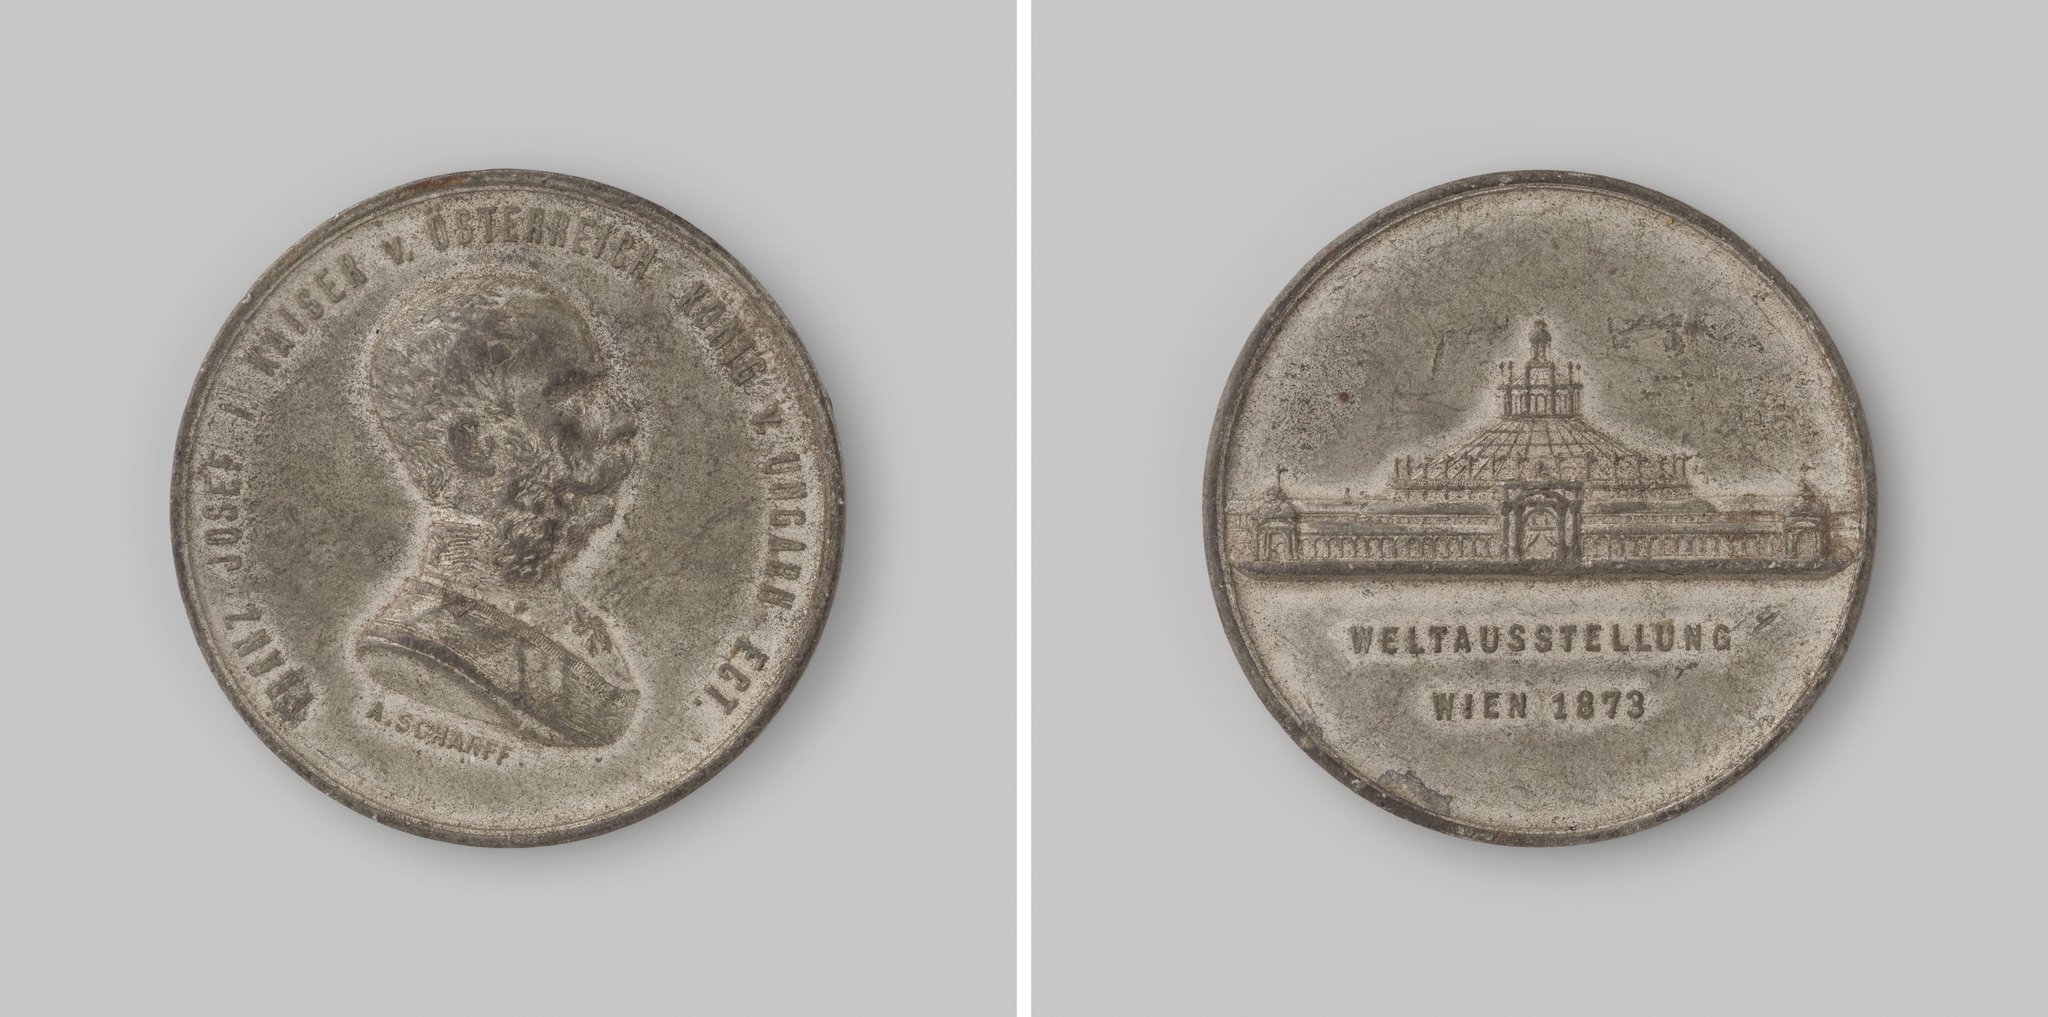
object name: history medal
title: Wereldtentoonstelling te Wenen 1872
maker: anton scharff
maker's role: medailleur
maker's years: 1845-1903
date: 1872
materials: tin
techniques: striking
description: Tinnen penning, op de voorzijde het borstbeeld van Keizer Frans Jozef naar rechts met omschrift, op de keerzijde het tentoonstellingsgebouw waaronder twee regels tekst.